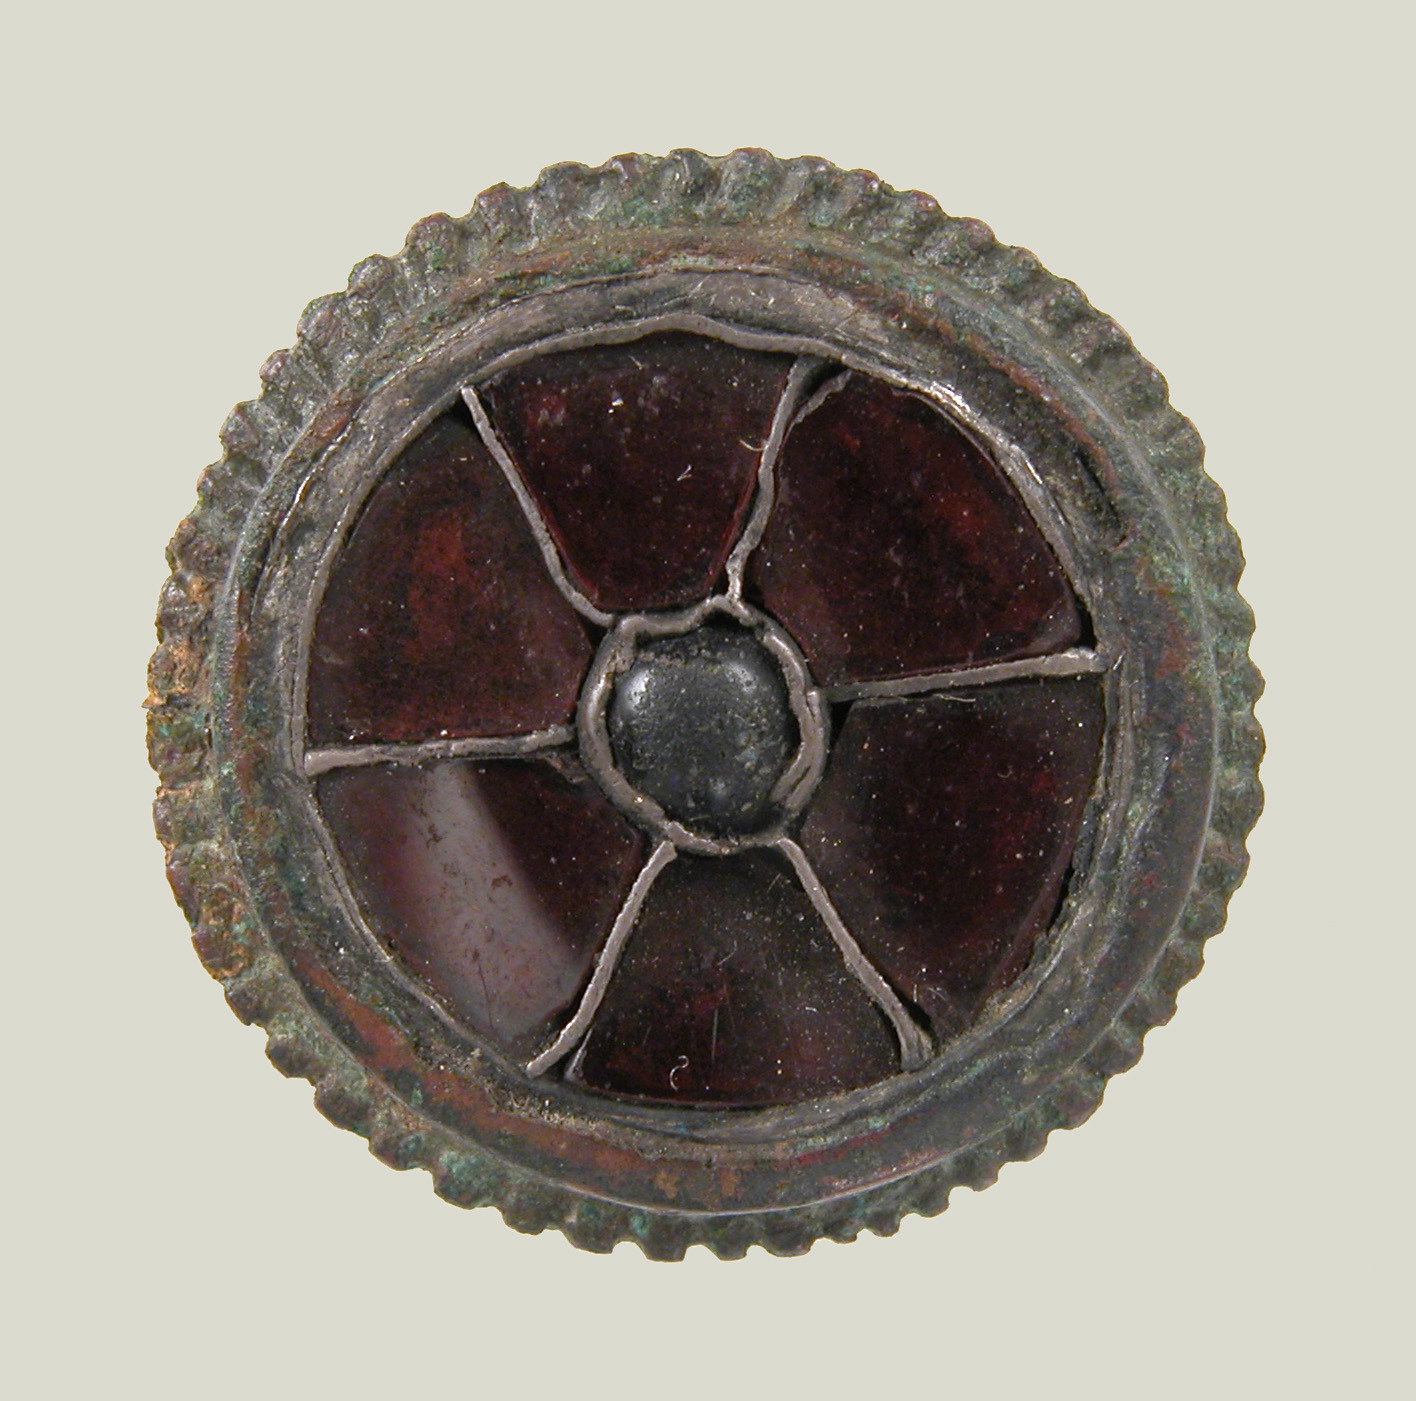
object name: brooch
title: Disk Brooch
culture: frankish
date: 501-600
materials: copper alloy, gemstone, glass, paste, silver